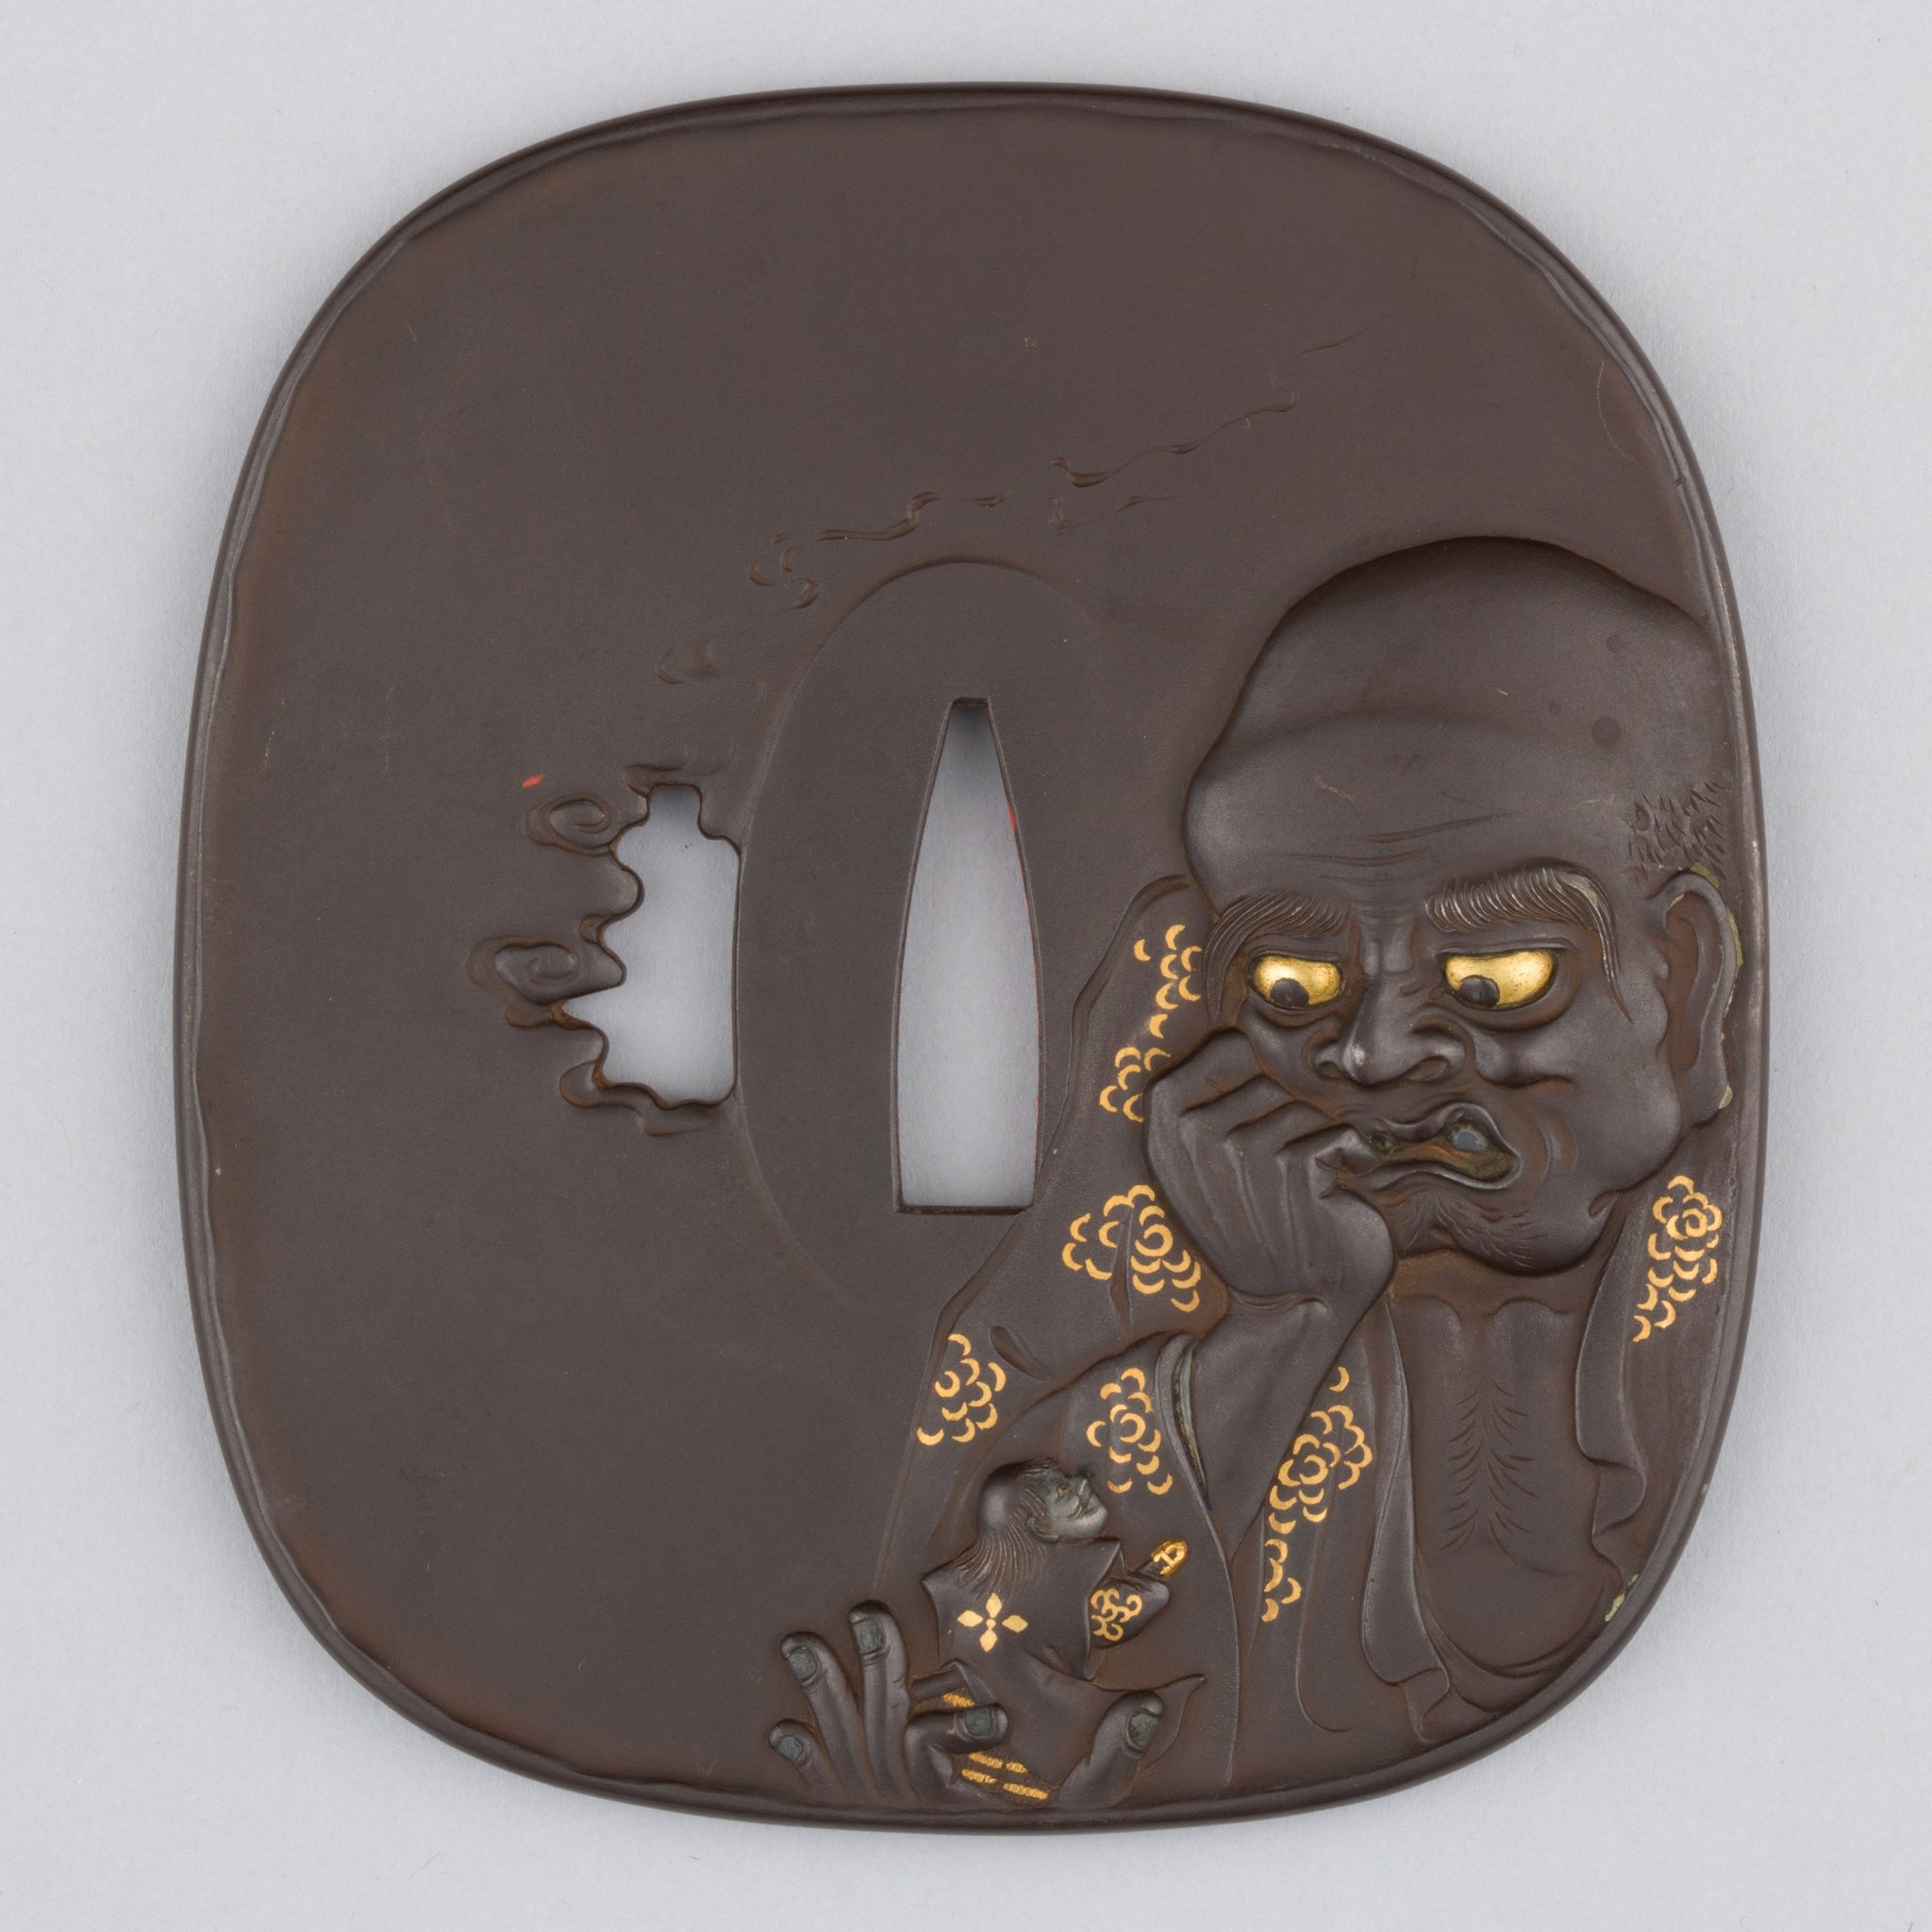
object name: sword guard tsuba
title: Sword Guard (Tsuba)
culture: japanese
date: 1615-1868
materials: copper, gold, iron, silver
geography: japan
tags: men